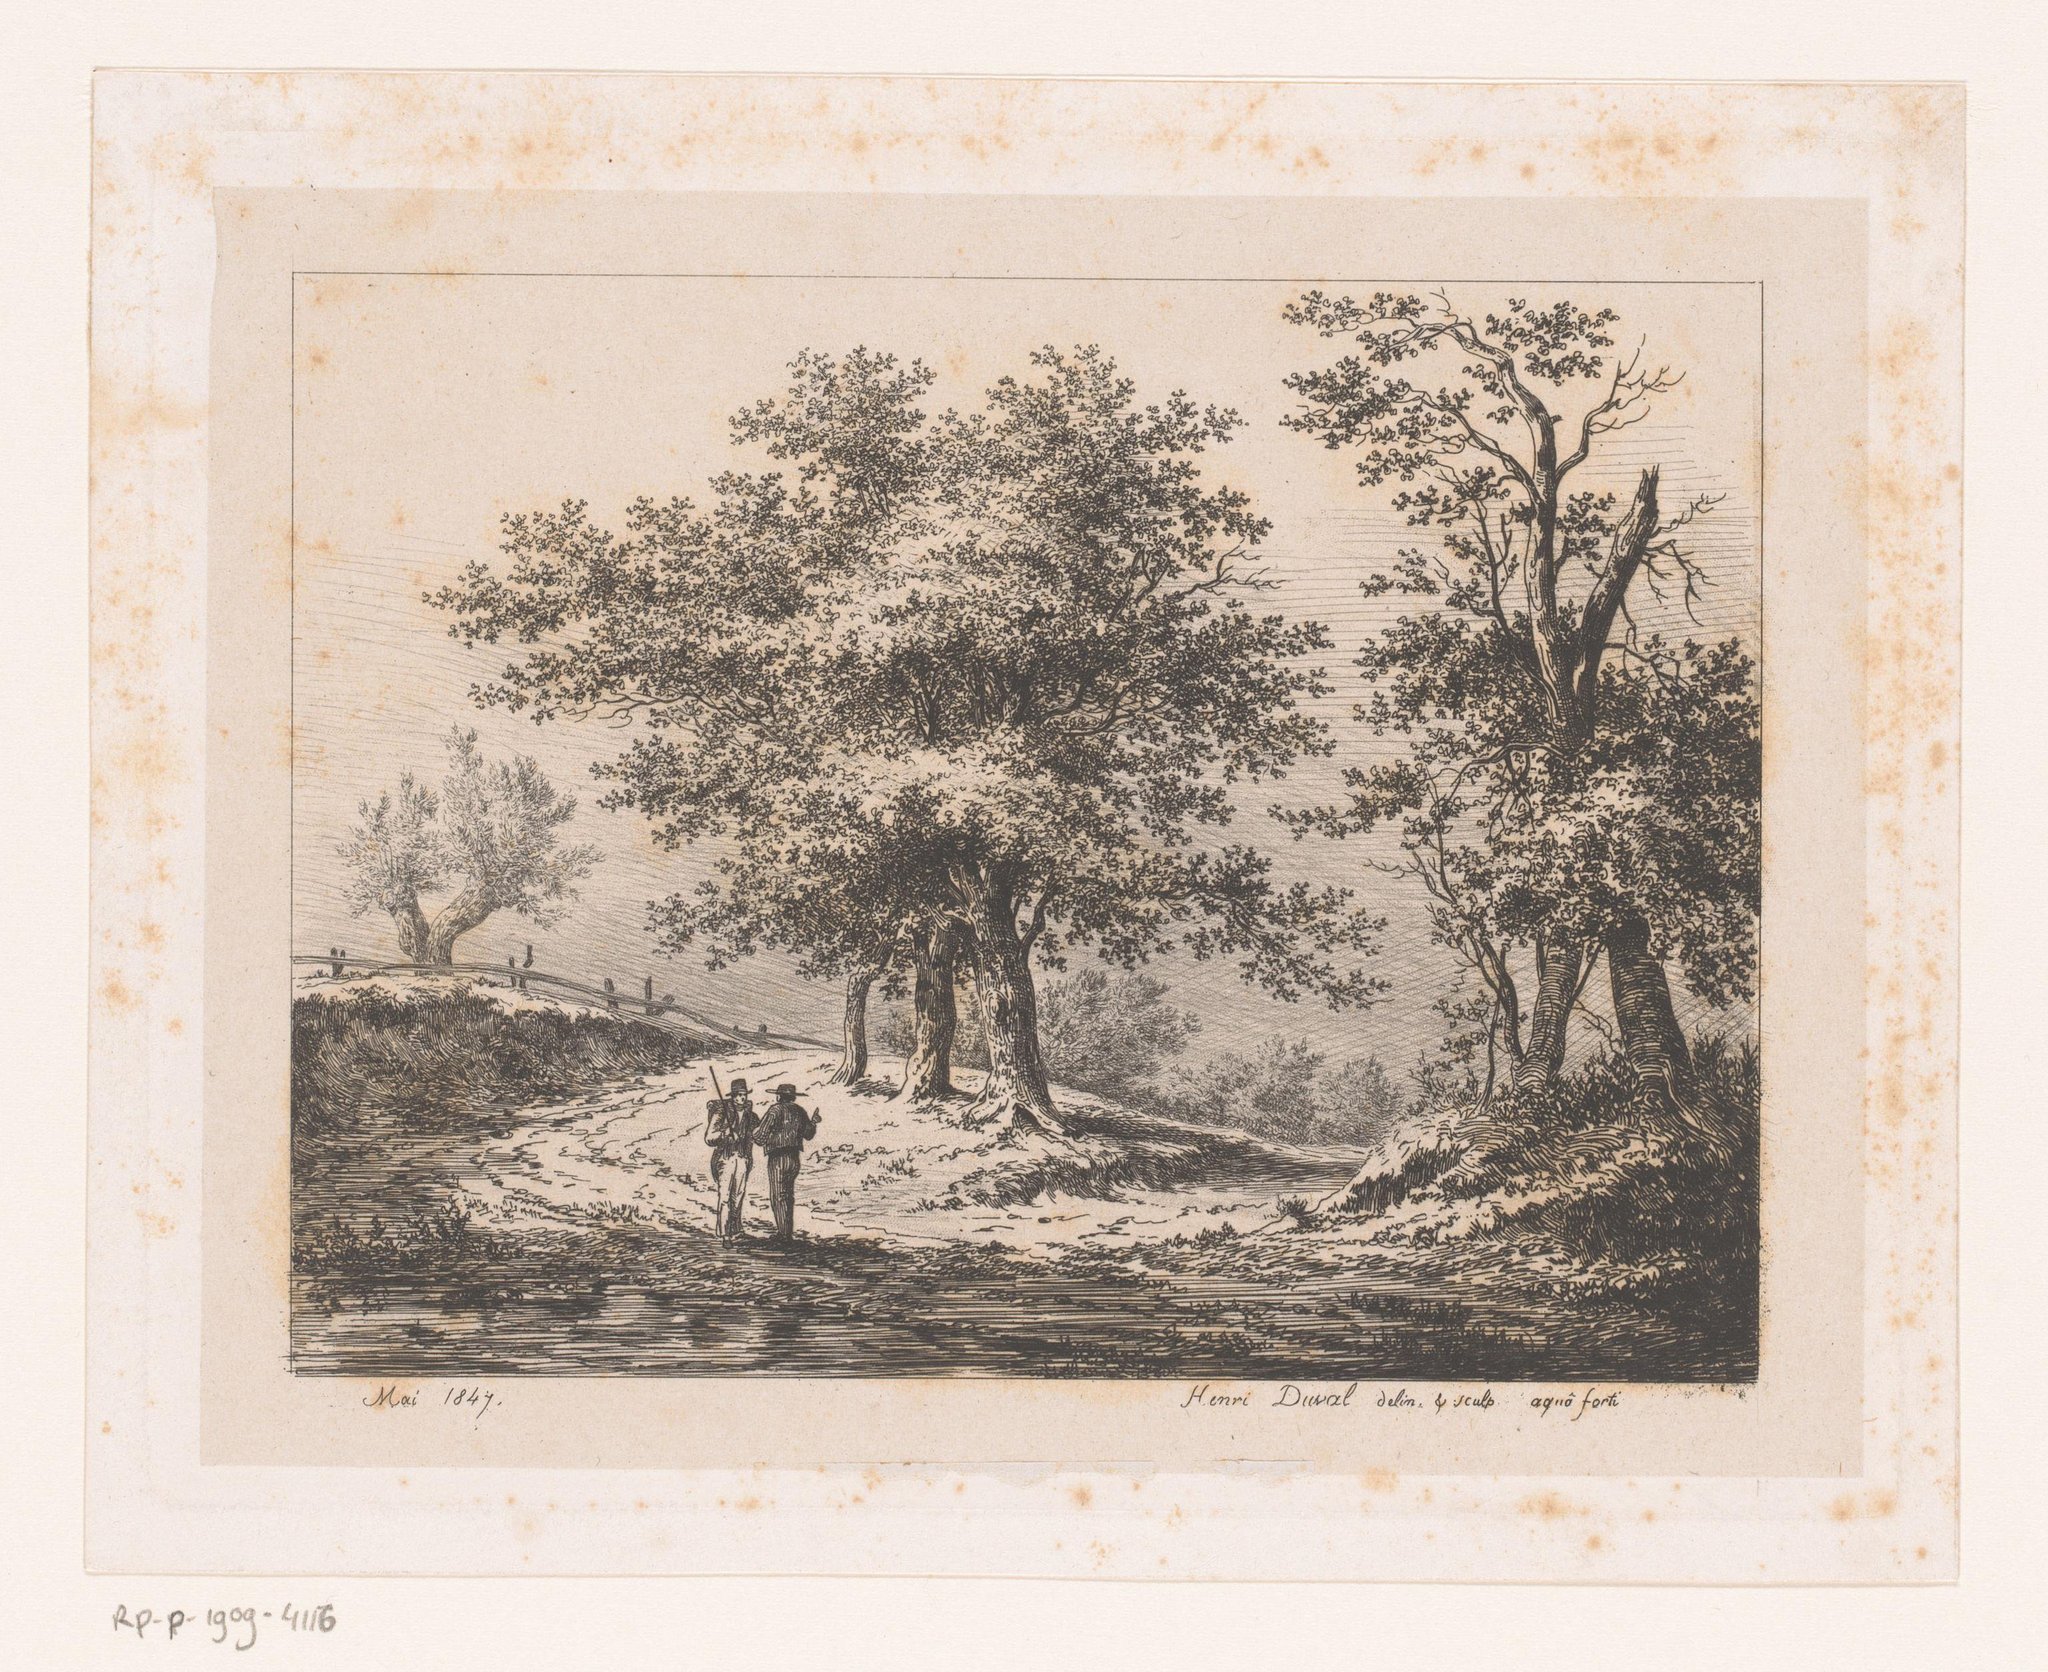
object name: print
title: Twee wandelaars op een landweg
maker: henri philippe adolphe duval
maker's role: print maker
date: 1847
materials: paper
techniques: etching, roulette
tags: walking, landscapes (+ landscape with figures, staffage)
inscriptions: collector's mark: Lugt 1485, collector's mark: Lugt 2228